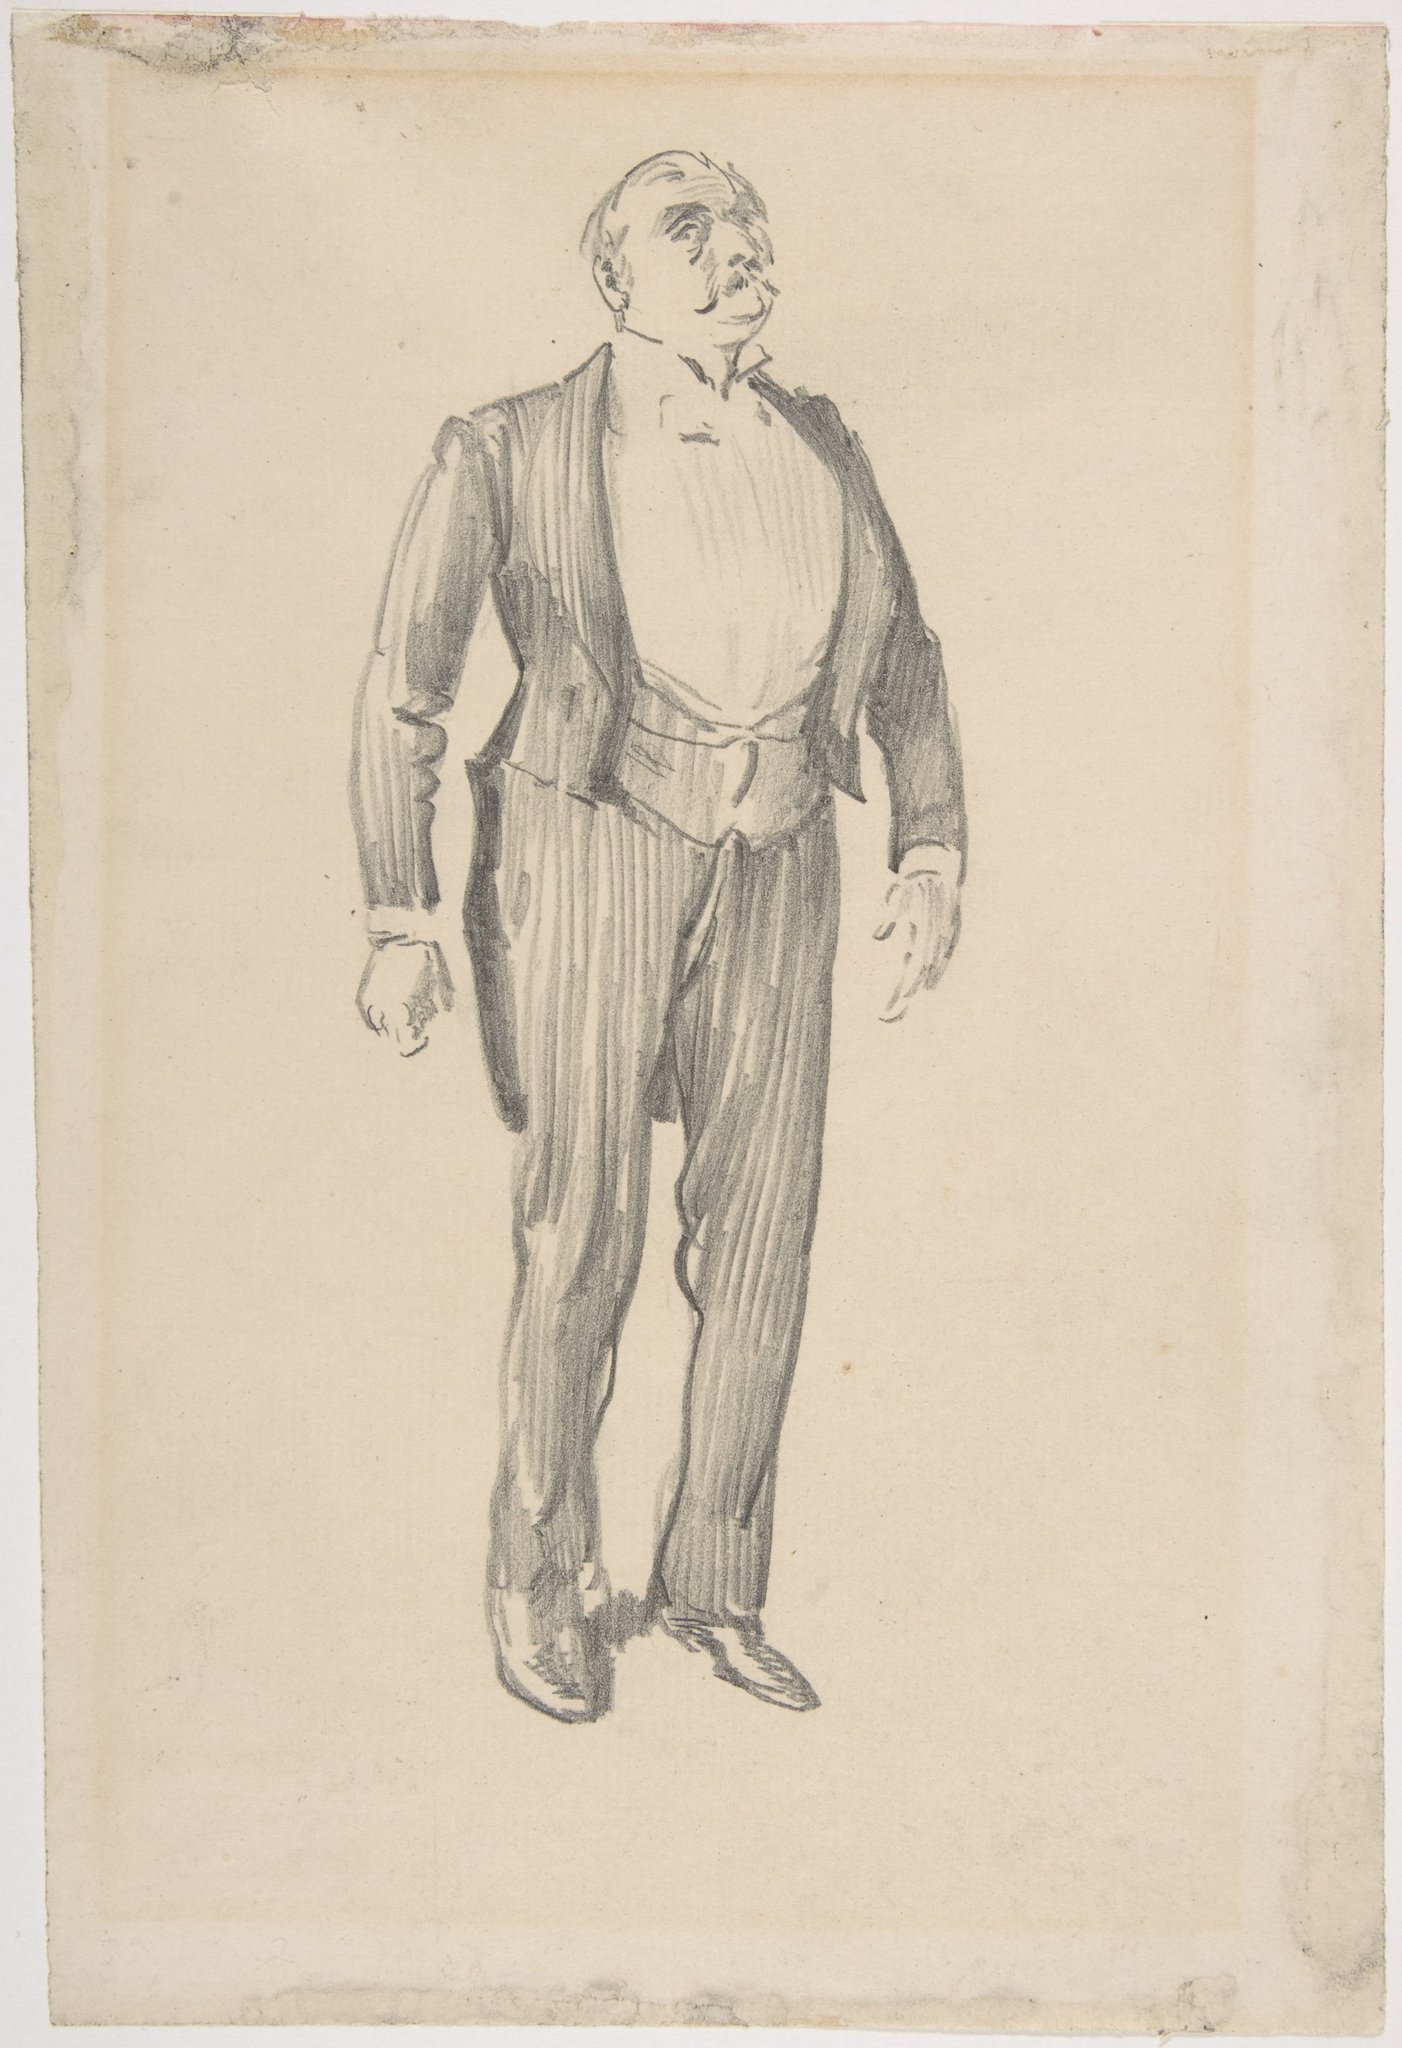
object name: drawing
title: Conductor: study from life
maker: george du maurier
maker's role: artist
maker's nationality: british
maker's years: 1834-1896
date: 1851-1900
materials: graphite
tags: men